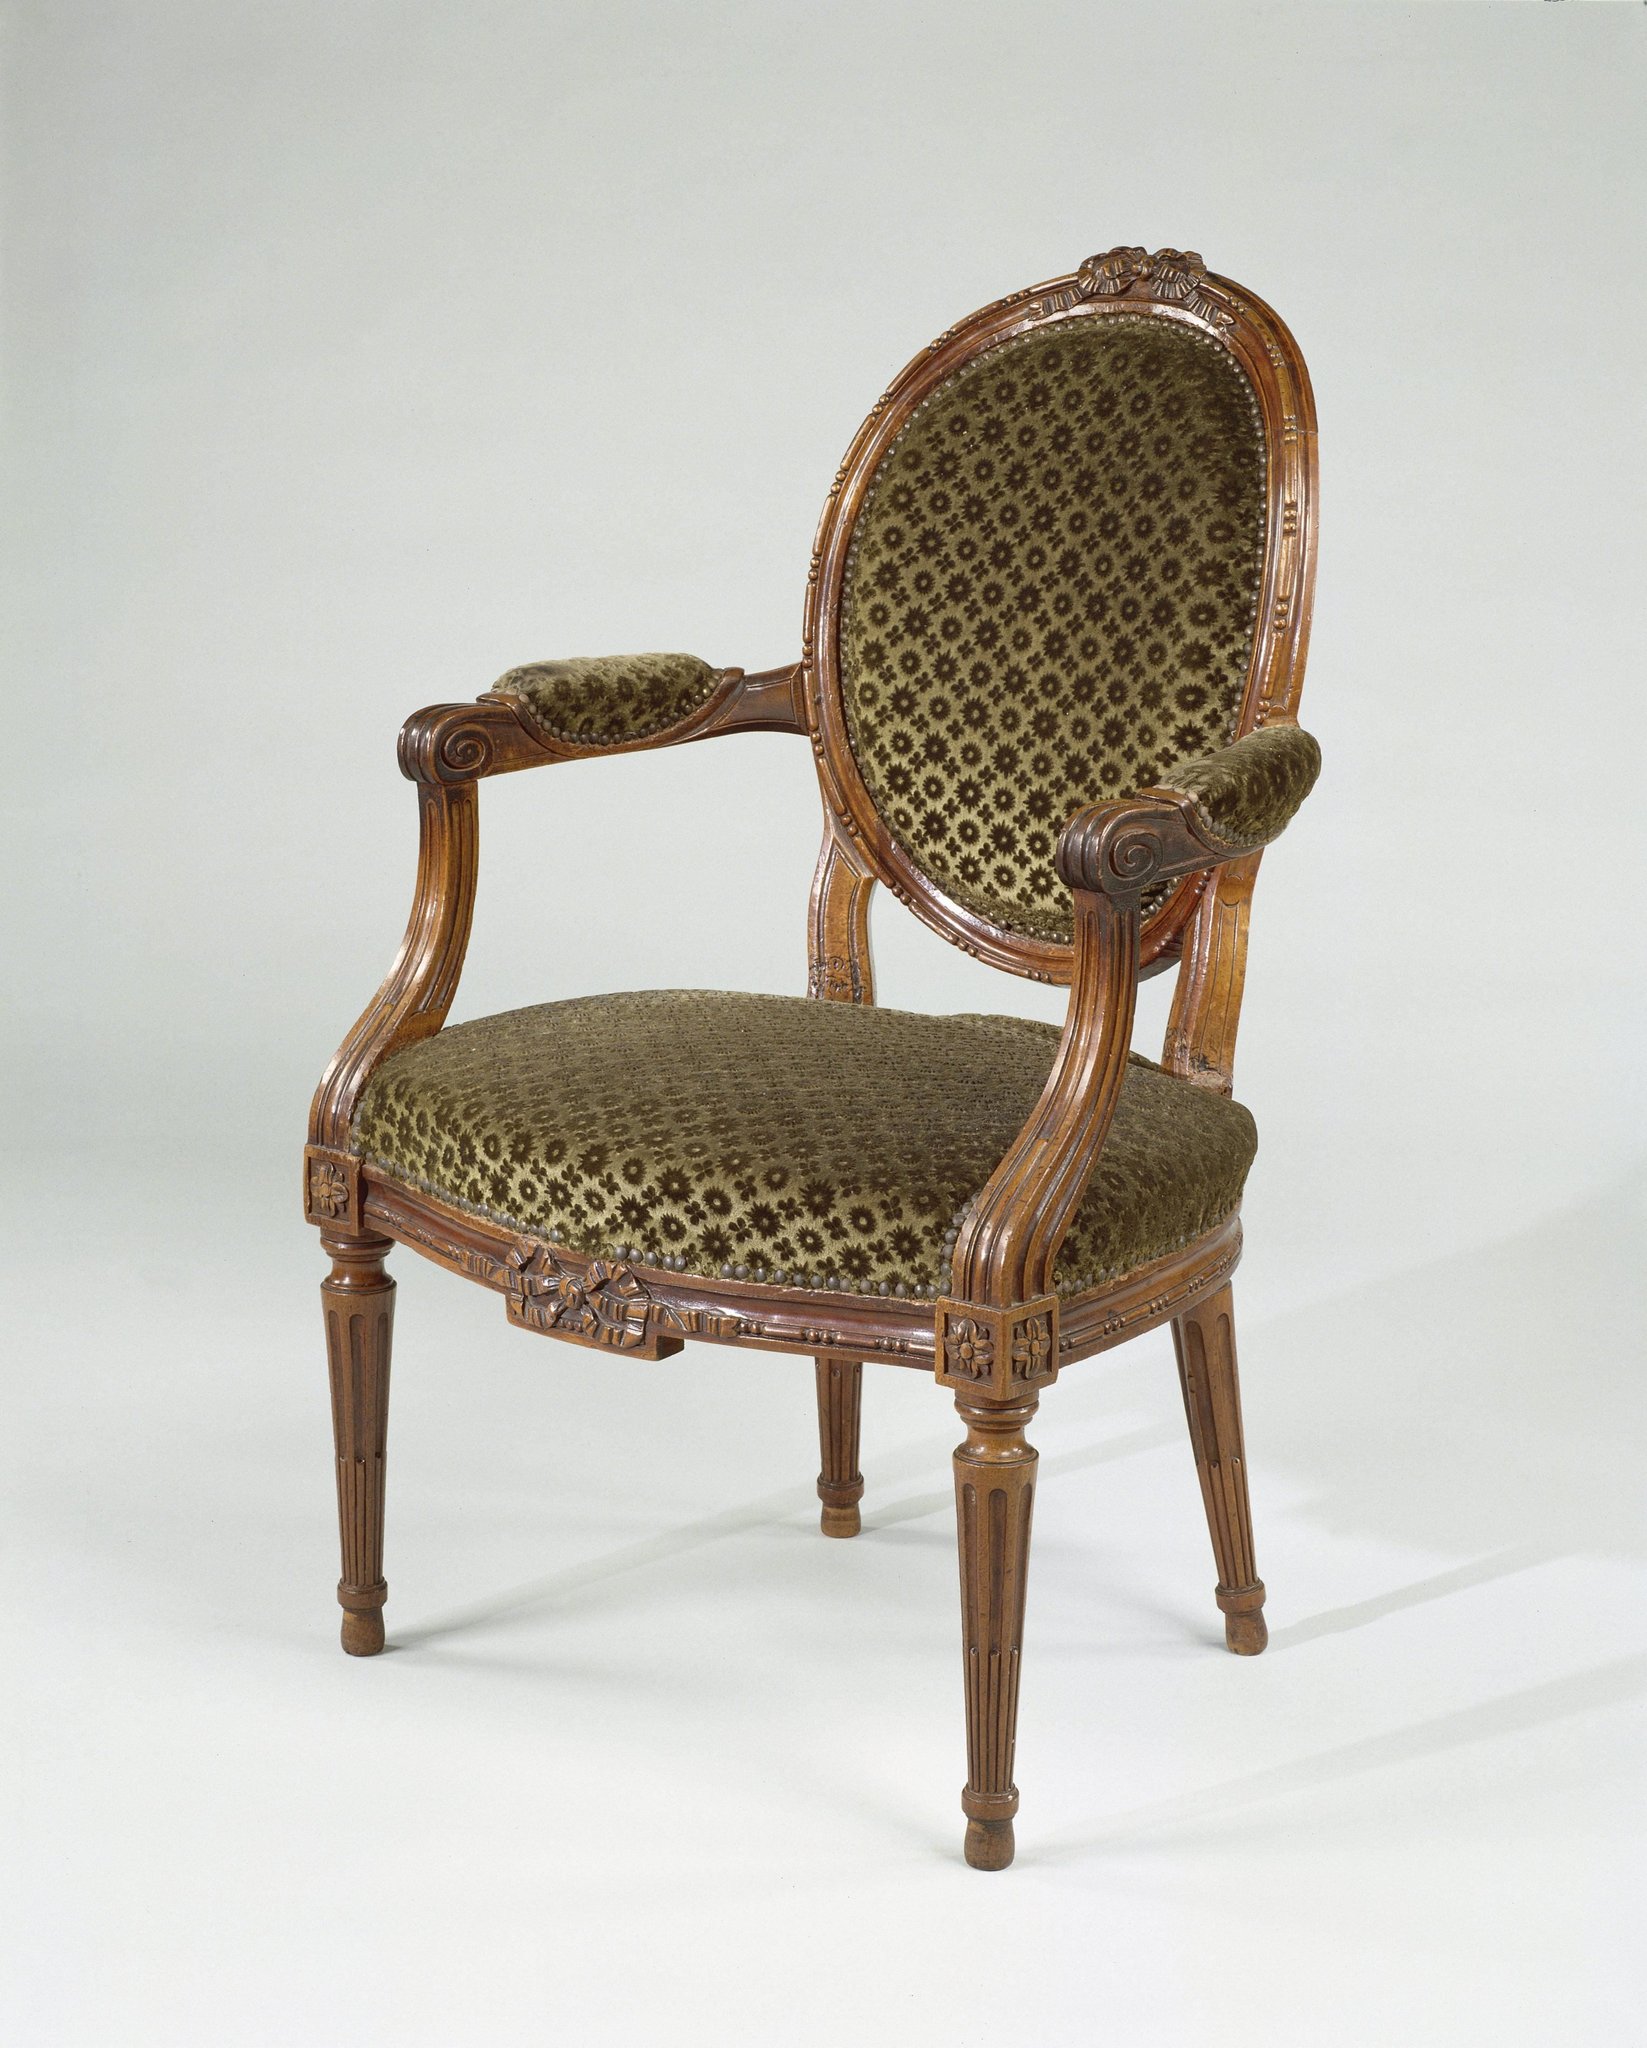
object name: furniture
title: Armstoel van mahoniehout, met conische, gecanneleerde poten en op voorzitregel versierd met een strik. Bekleed met groene velours met patroon van rozetten. Bekleding niet origineel.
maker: Anonymous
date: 1780-1790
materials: wood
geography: netherlands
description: Armchair. Mahogany, upholstered with a woollen velvet (renewed). Netherlands, c. 1780 - 1790.